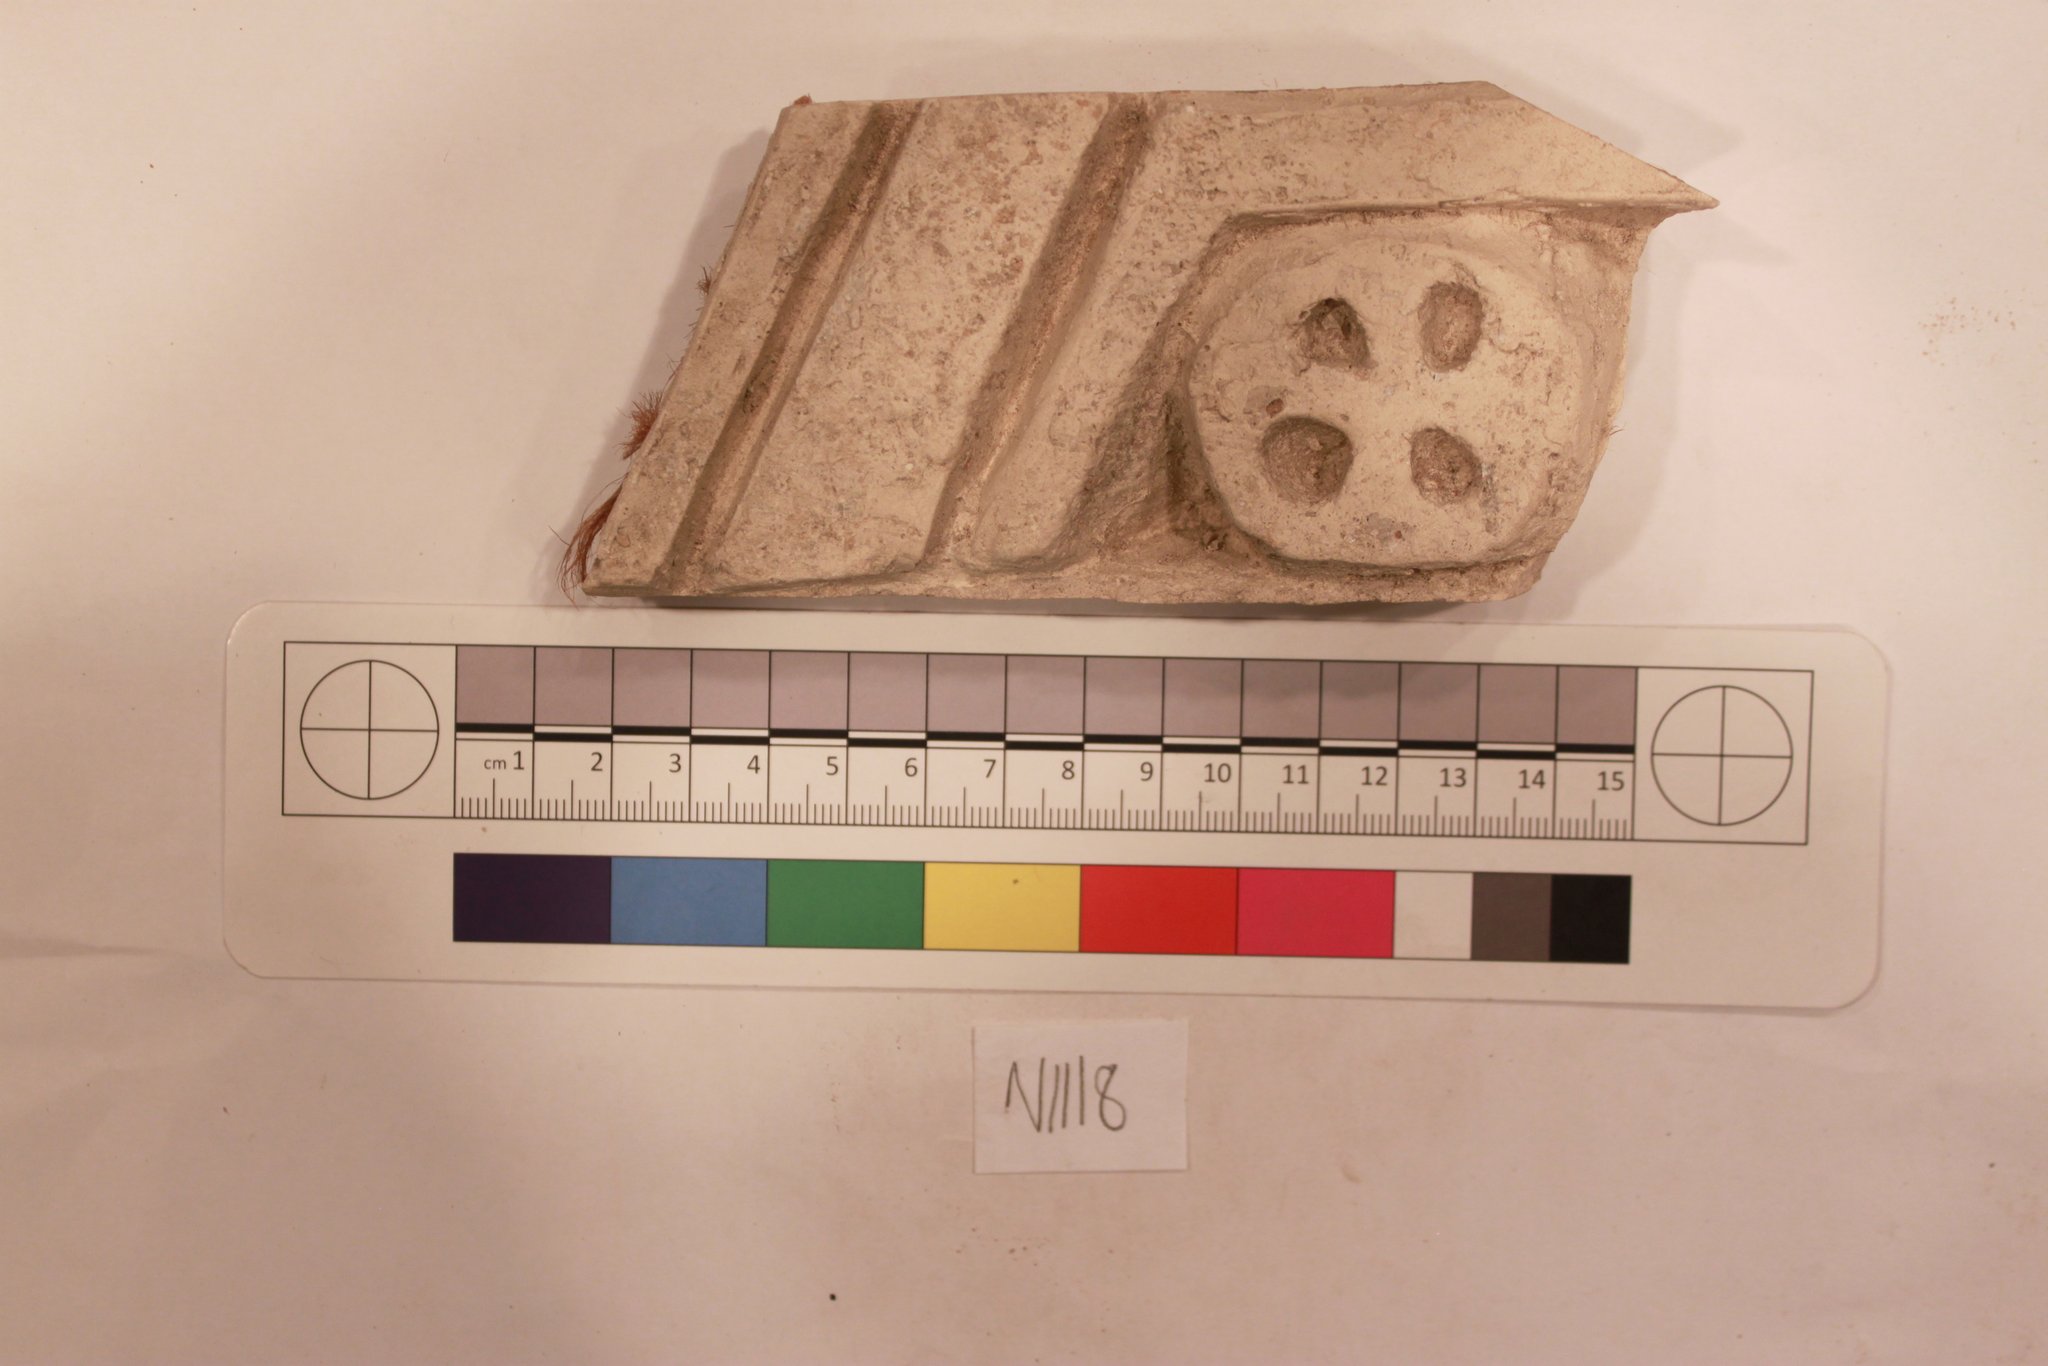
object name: fragment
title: Stucco Fragment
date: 701-1200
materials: gypsum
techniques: carving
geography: iran